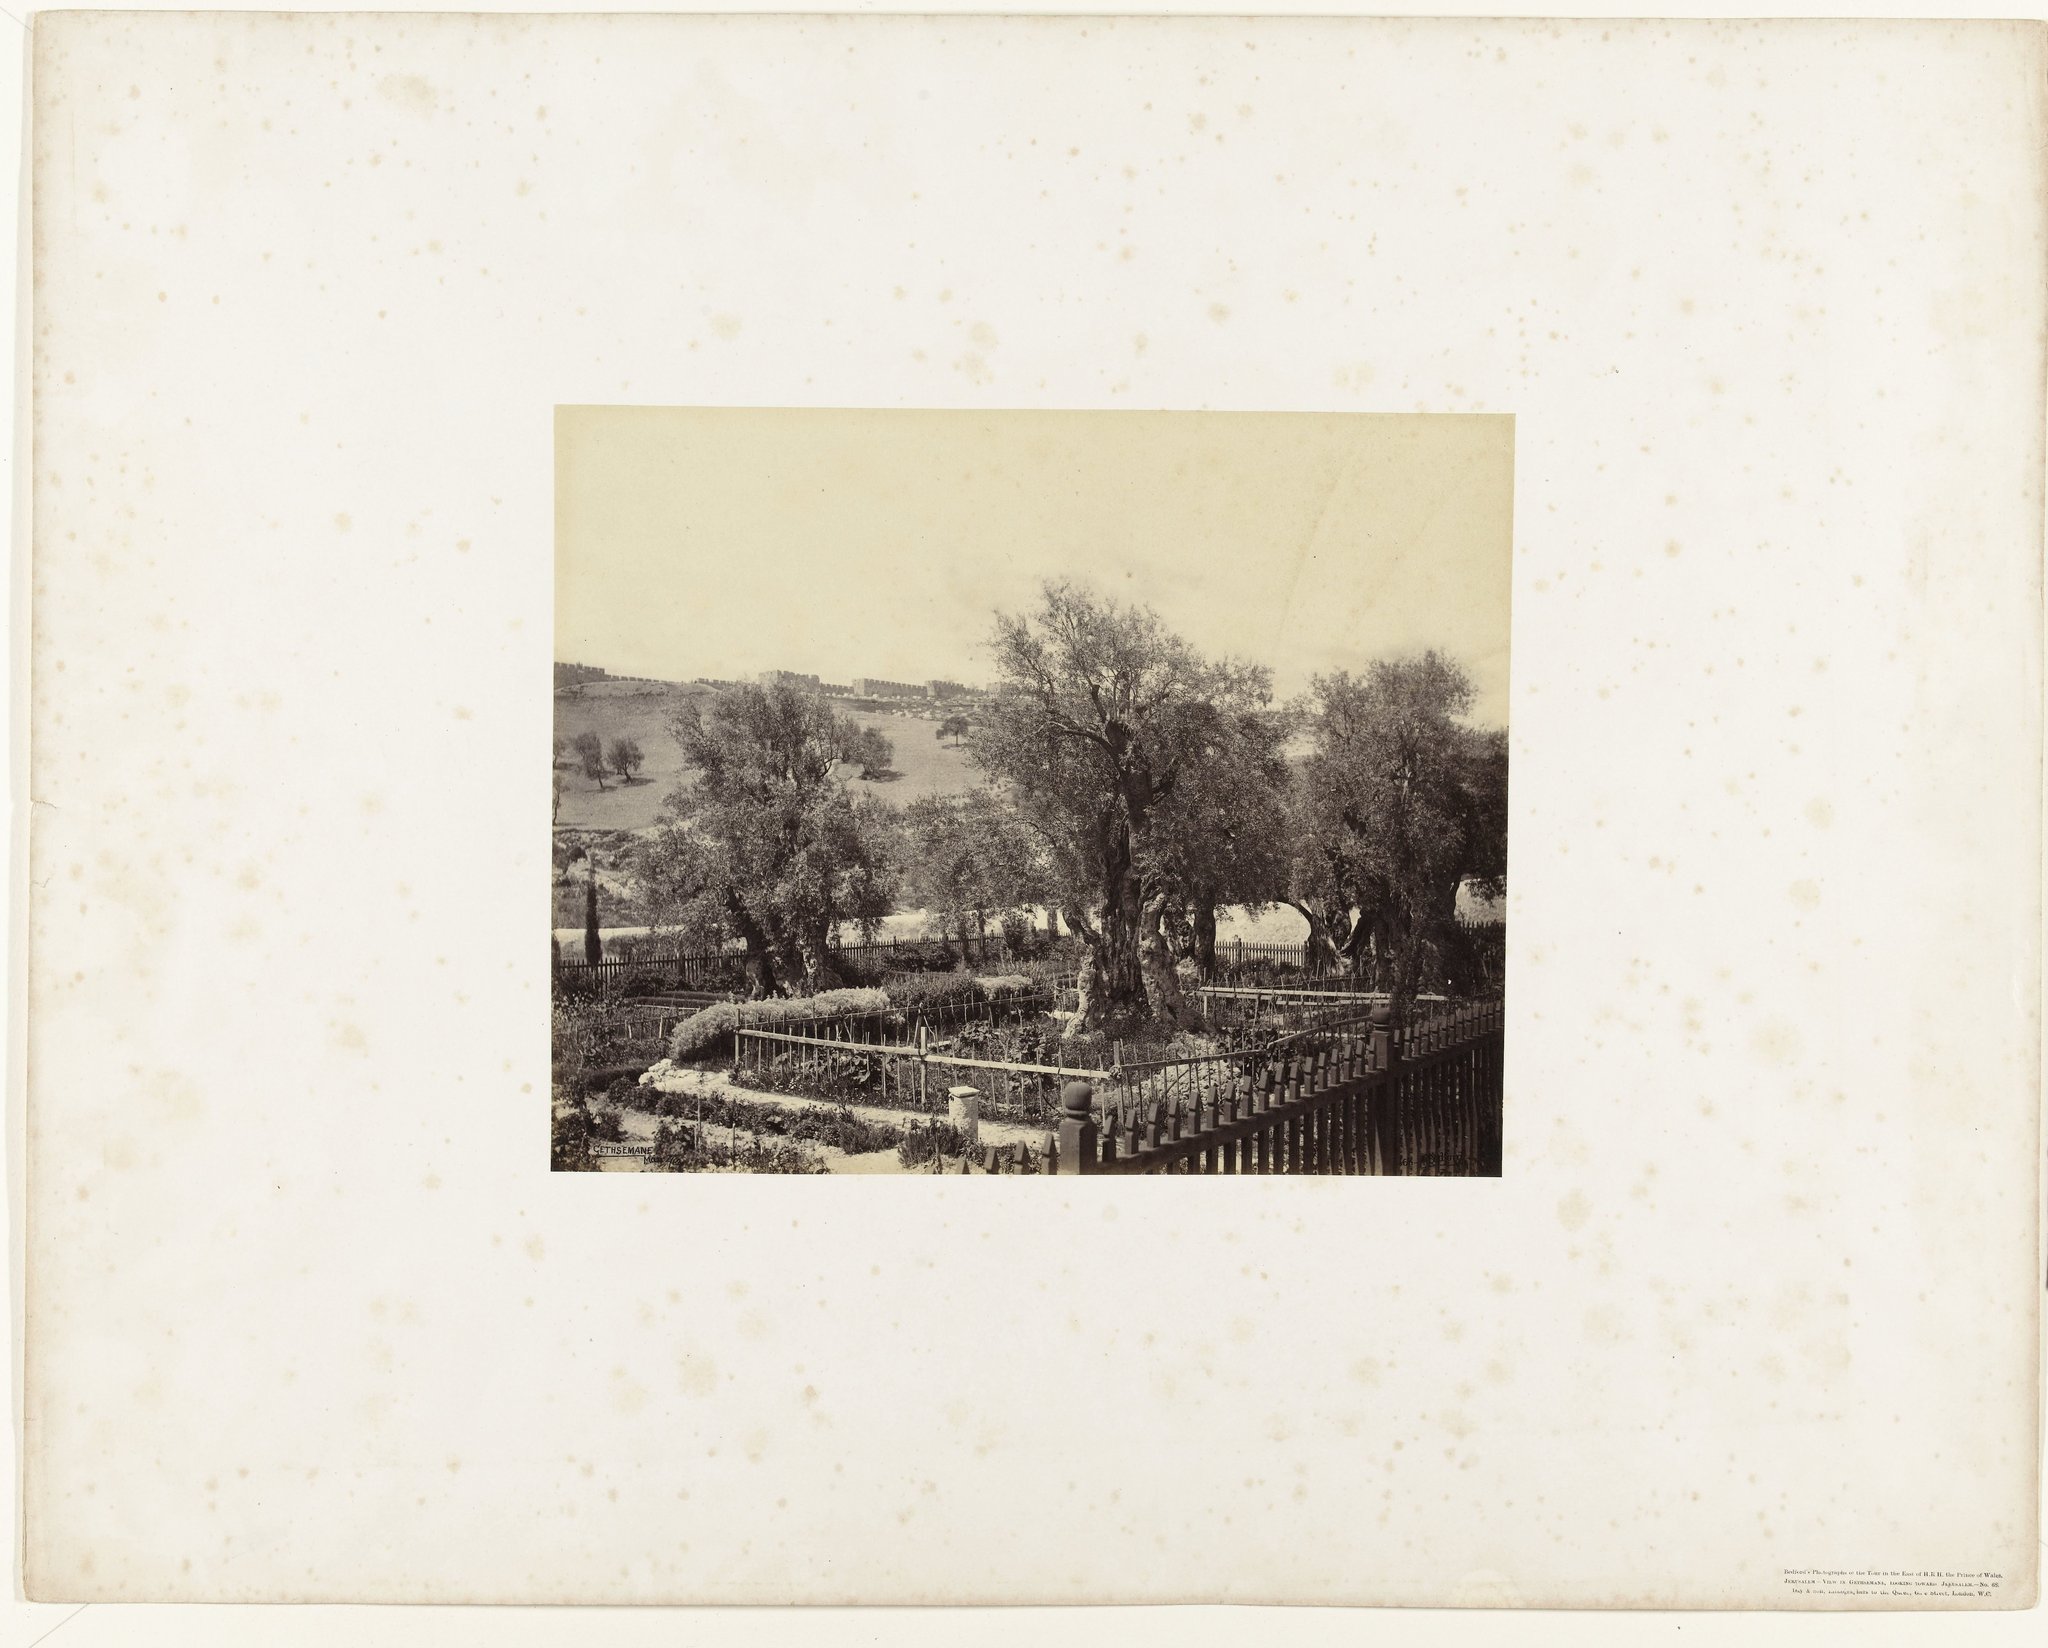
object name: photograph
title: Jerusalem - View in Gethsemane, Looking toward Jerusalem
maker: francis bedford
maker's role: print maker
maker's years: 1815-1894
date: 1862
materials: cardboard, photographic support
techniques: albumen print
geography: london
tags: olijfberg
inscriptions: date